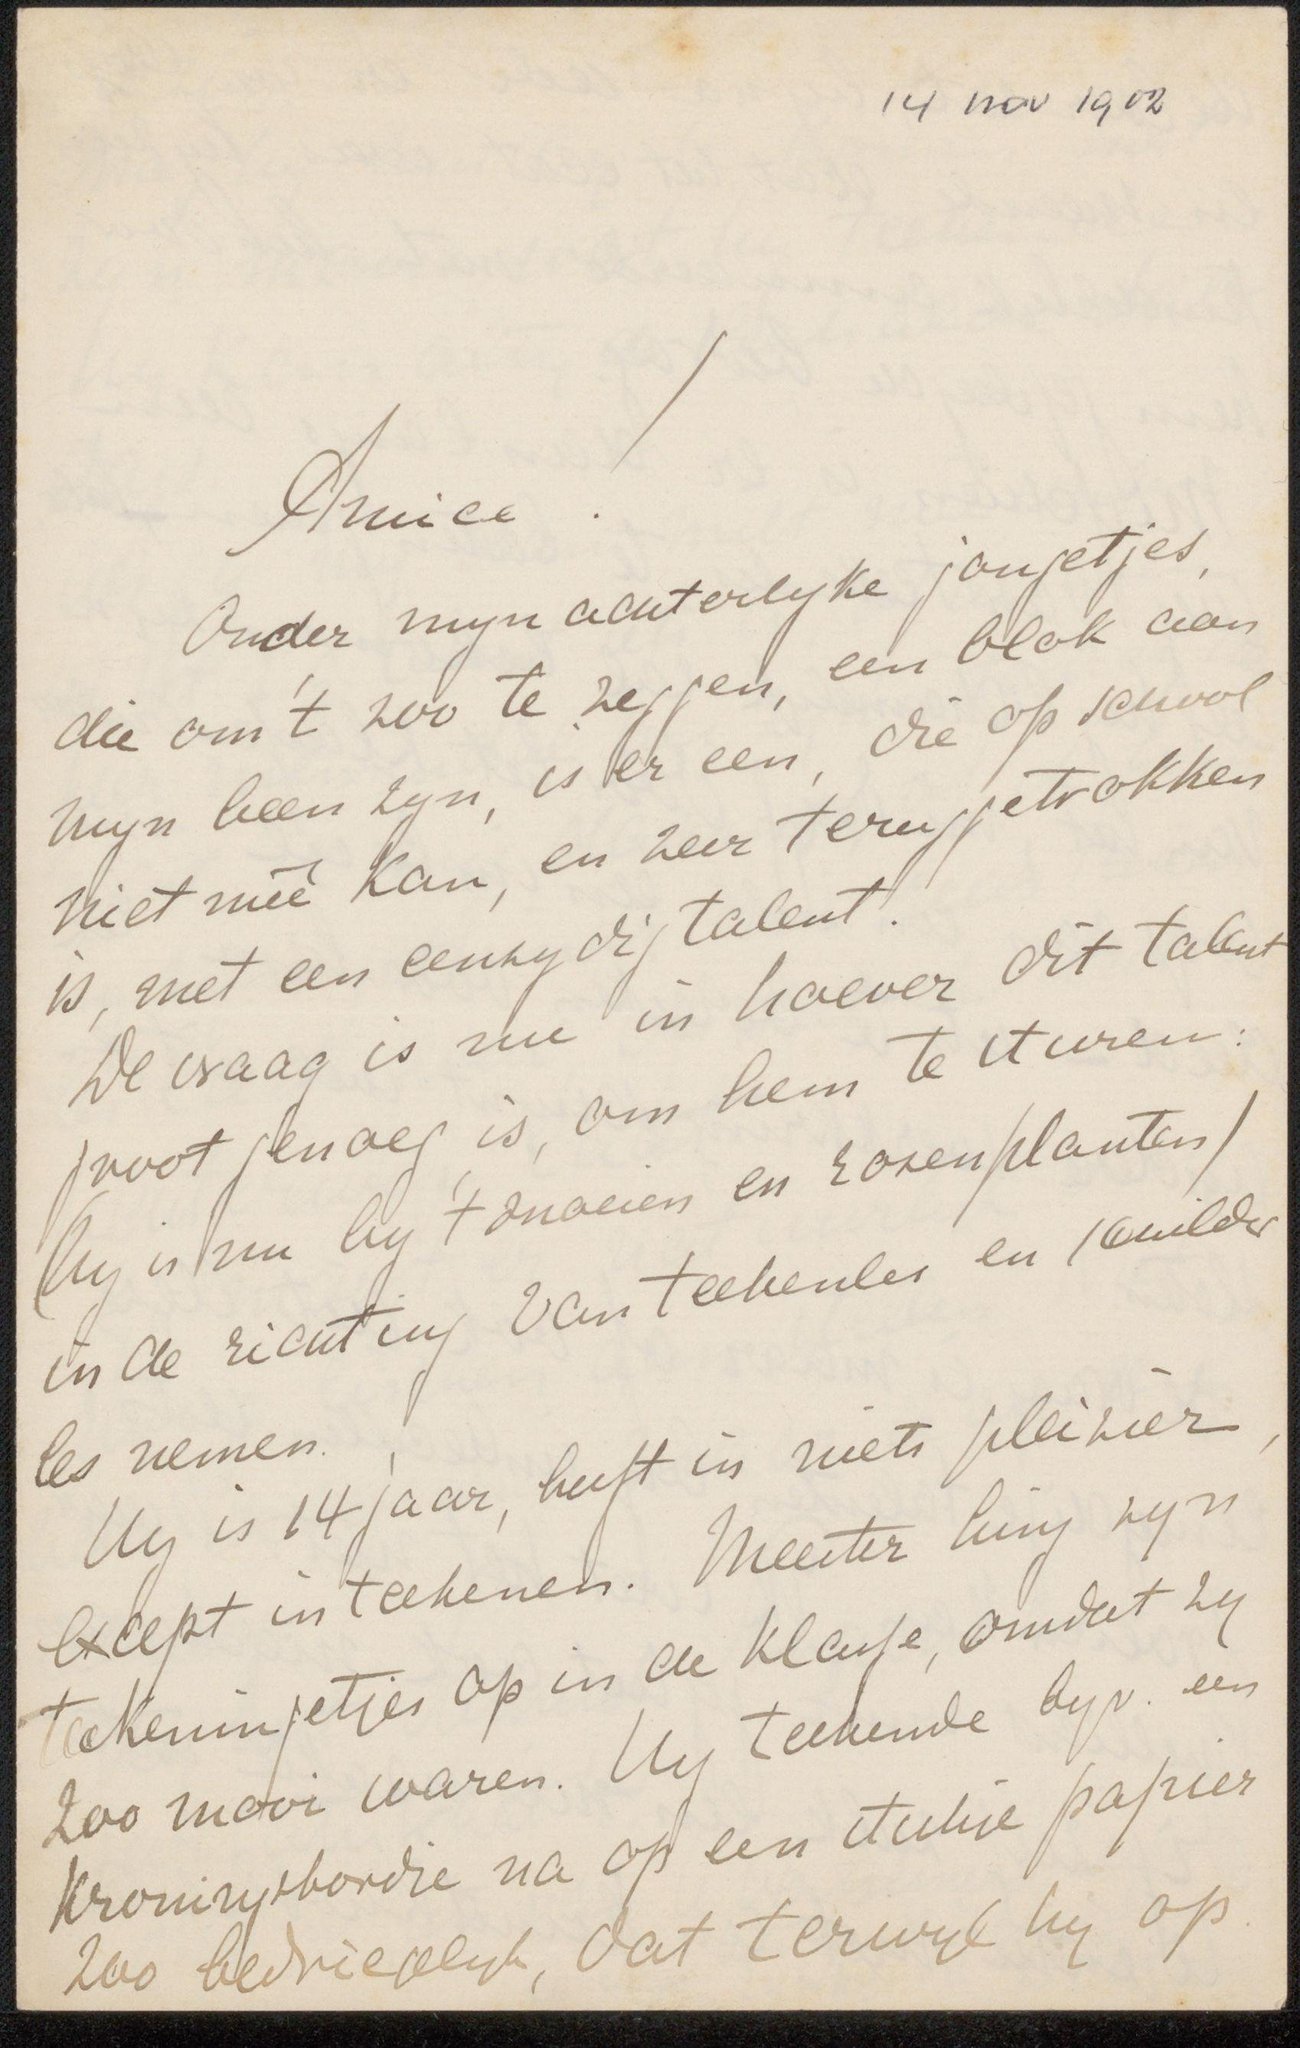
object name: letter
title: Brief aan Jan Veth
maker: cornelis winkler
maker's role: hoogleraar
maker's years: 1855-1941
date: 1902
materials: ink, paper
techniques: pen, writing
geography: amsterdam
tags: dordrecht, amsterdam, painter, print maker, draughtsman, designer, jan veth, education, tuition of the artist (in general), painting (including book-illumination, miniature-painting), diseases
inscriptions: collector's mark: ‘RPK’